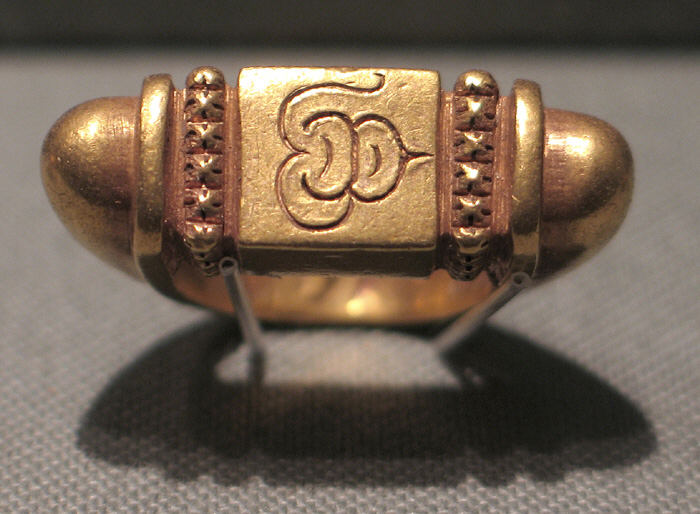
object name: ring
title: Stirrup-Shaped Ring with Rectangular Bezel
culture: indonesian, javanese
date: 701-933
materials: gold